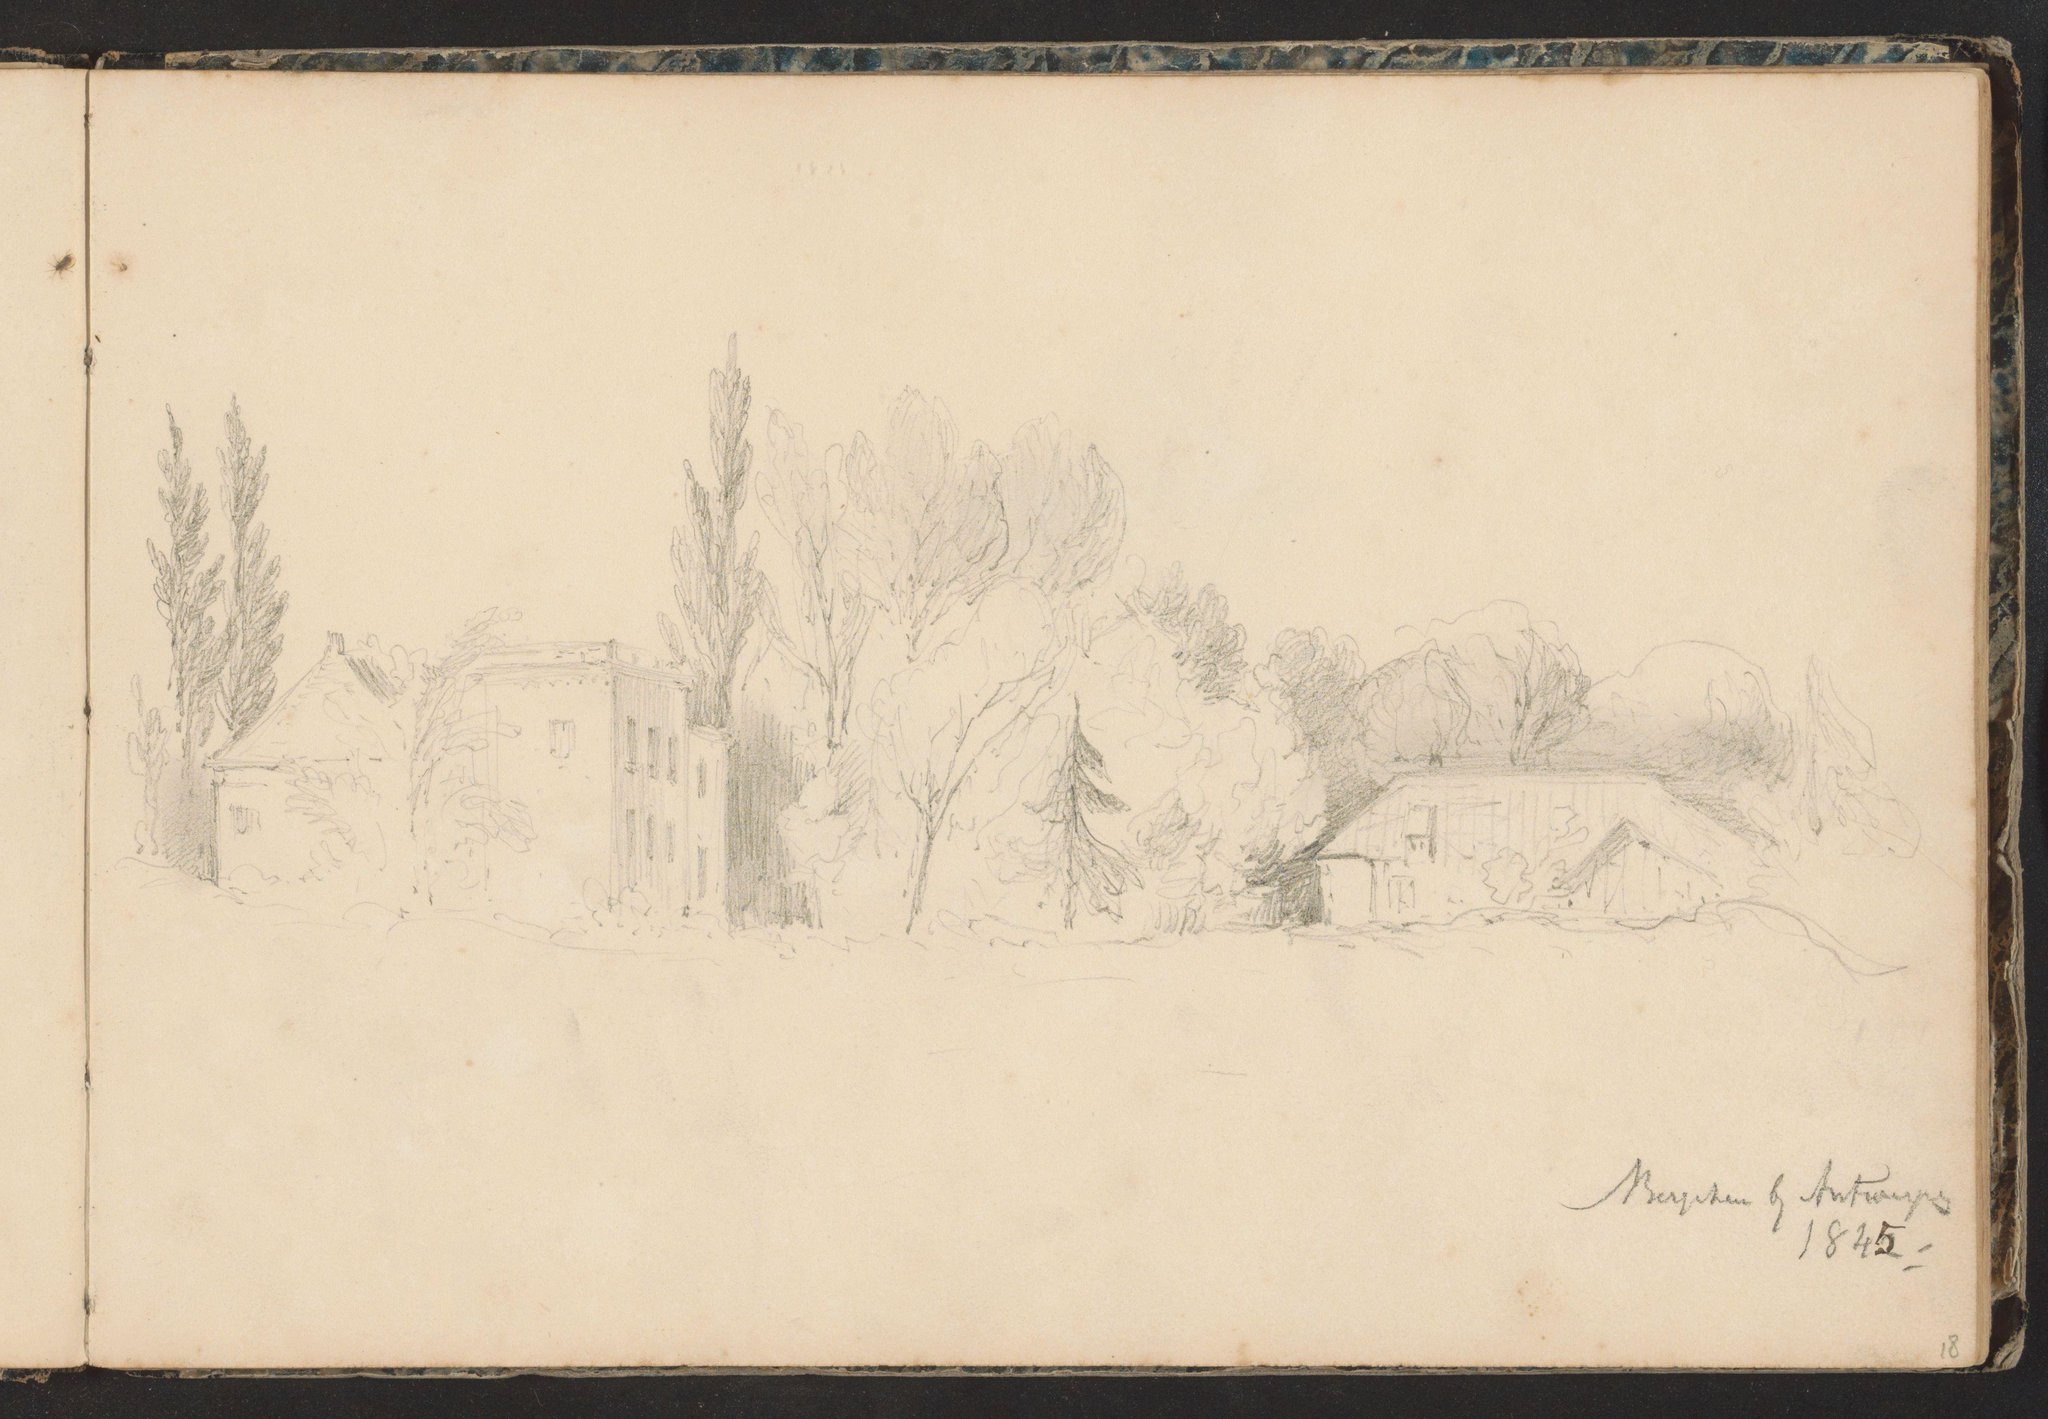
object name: sketchbook leaf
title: Berchem bij Antwerpen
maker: johannes tavenraat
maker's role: draughtsman, painter, print maker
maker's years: 1809-1881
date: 1845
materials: paper, pencil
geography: berchem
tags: city-view, and landscape with man-made constructions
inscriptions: date and inscription: ‘Berghem bij Antwerpen/ 1845.’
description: Blad 18 recto uit een schetsboek met 44 bladen.